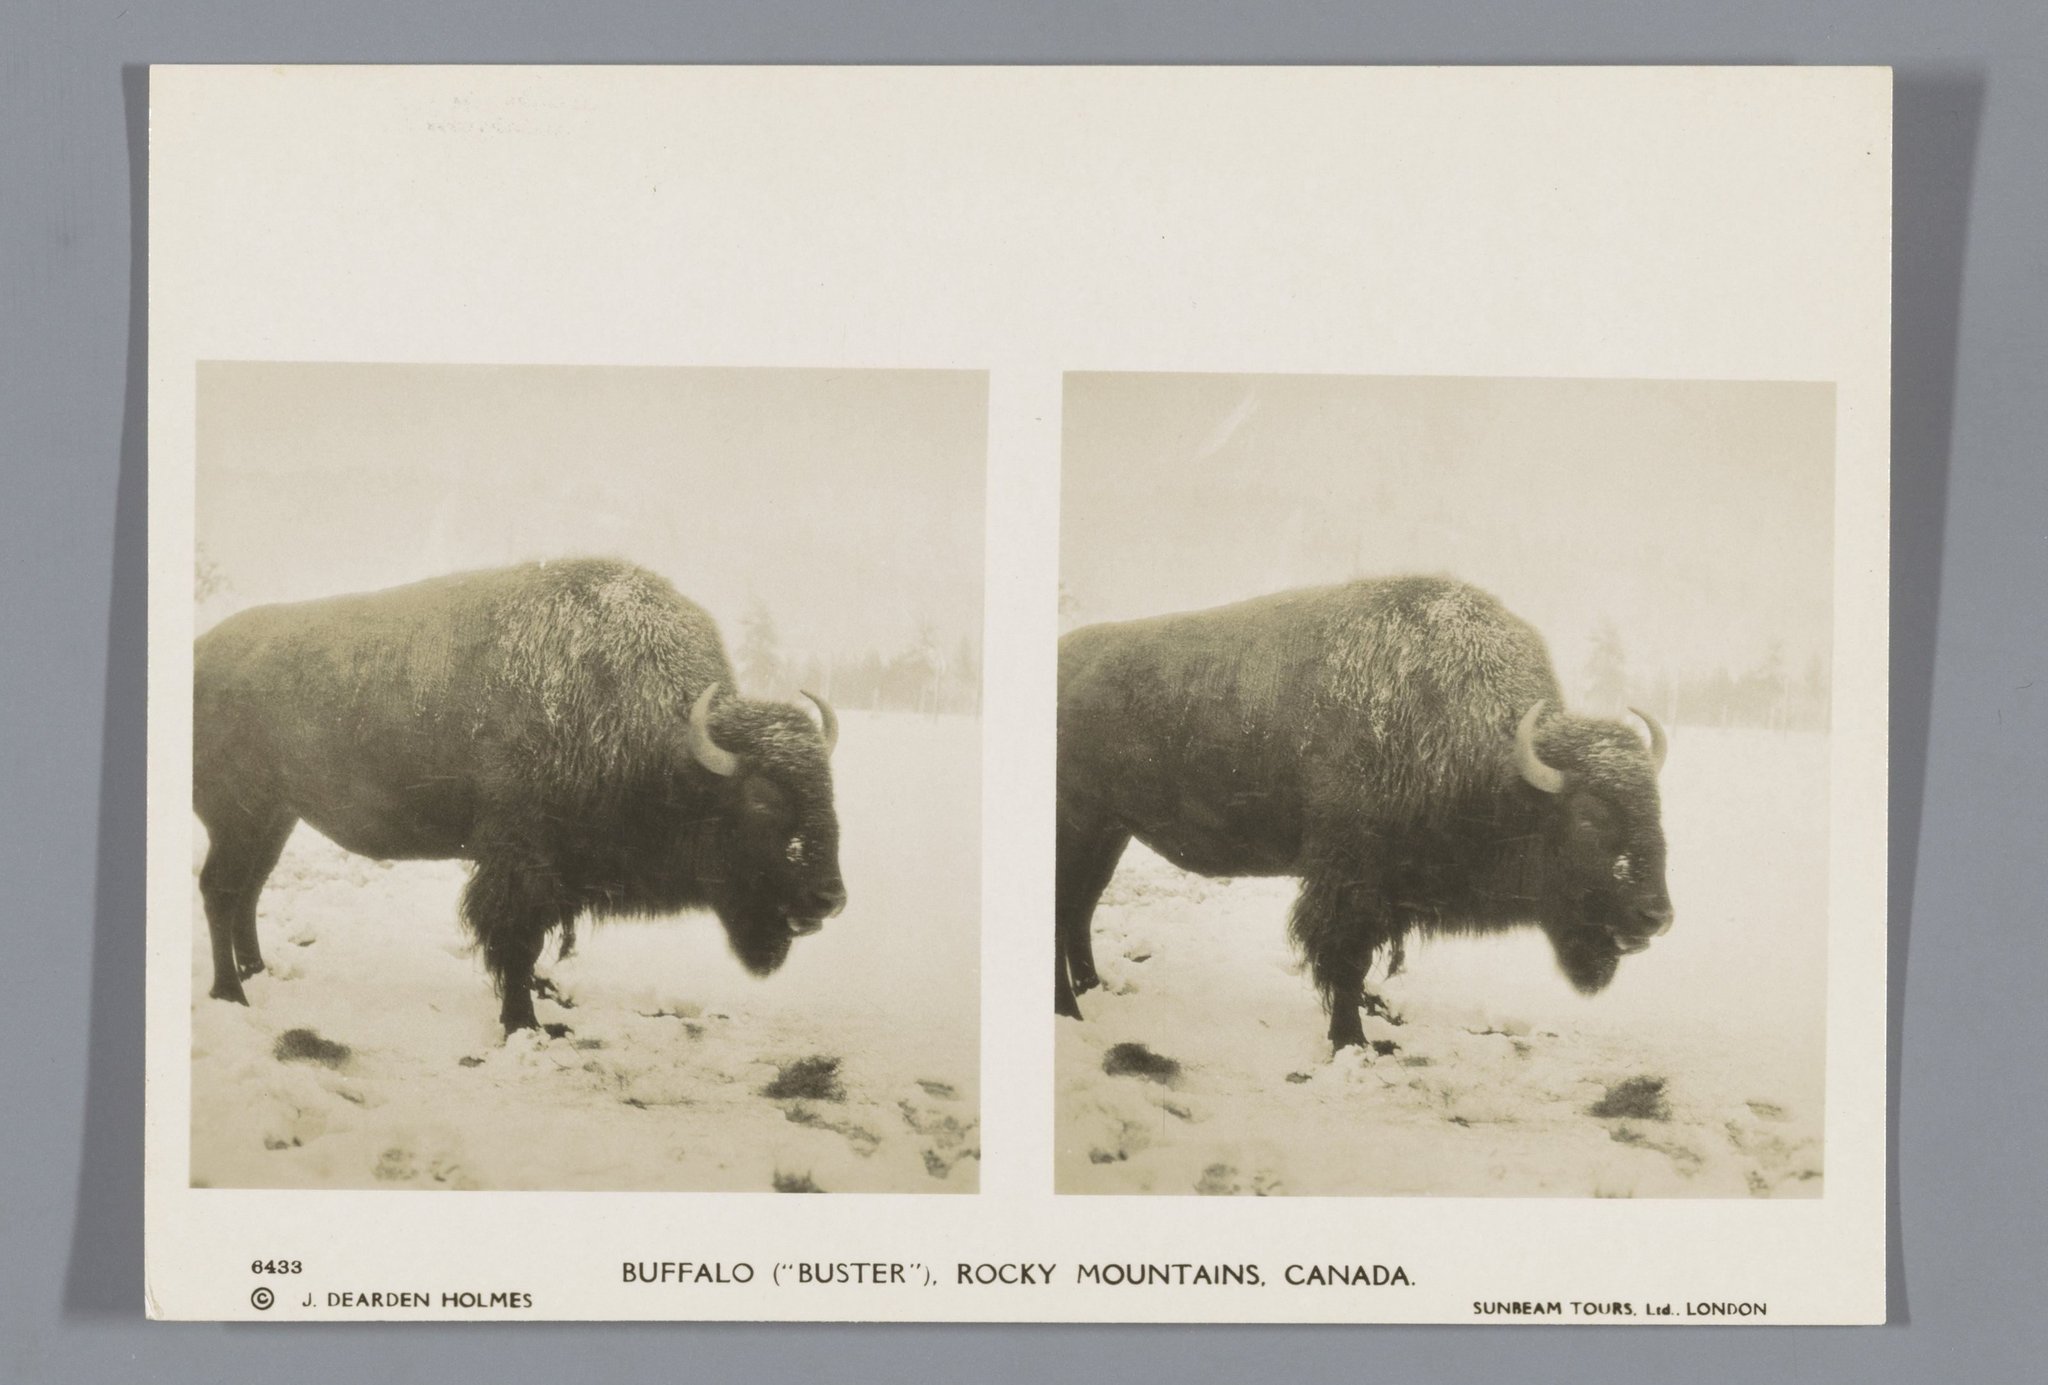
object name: stereograph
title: Buffalo ("Buster"), Rocky Mountains, Canada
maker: james dearden holmes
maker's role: fotograaf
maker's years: 1873-1937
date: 1924-1926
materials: paper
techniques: gelatin silver print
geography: birmingham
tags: hoofed animals: bison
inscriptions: number: ‘6433’